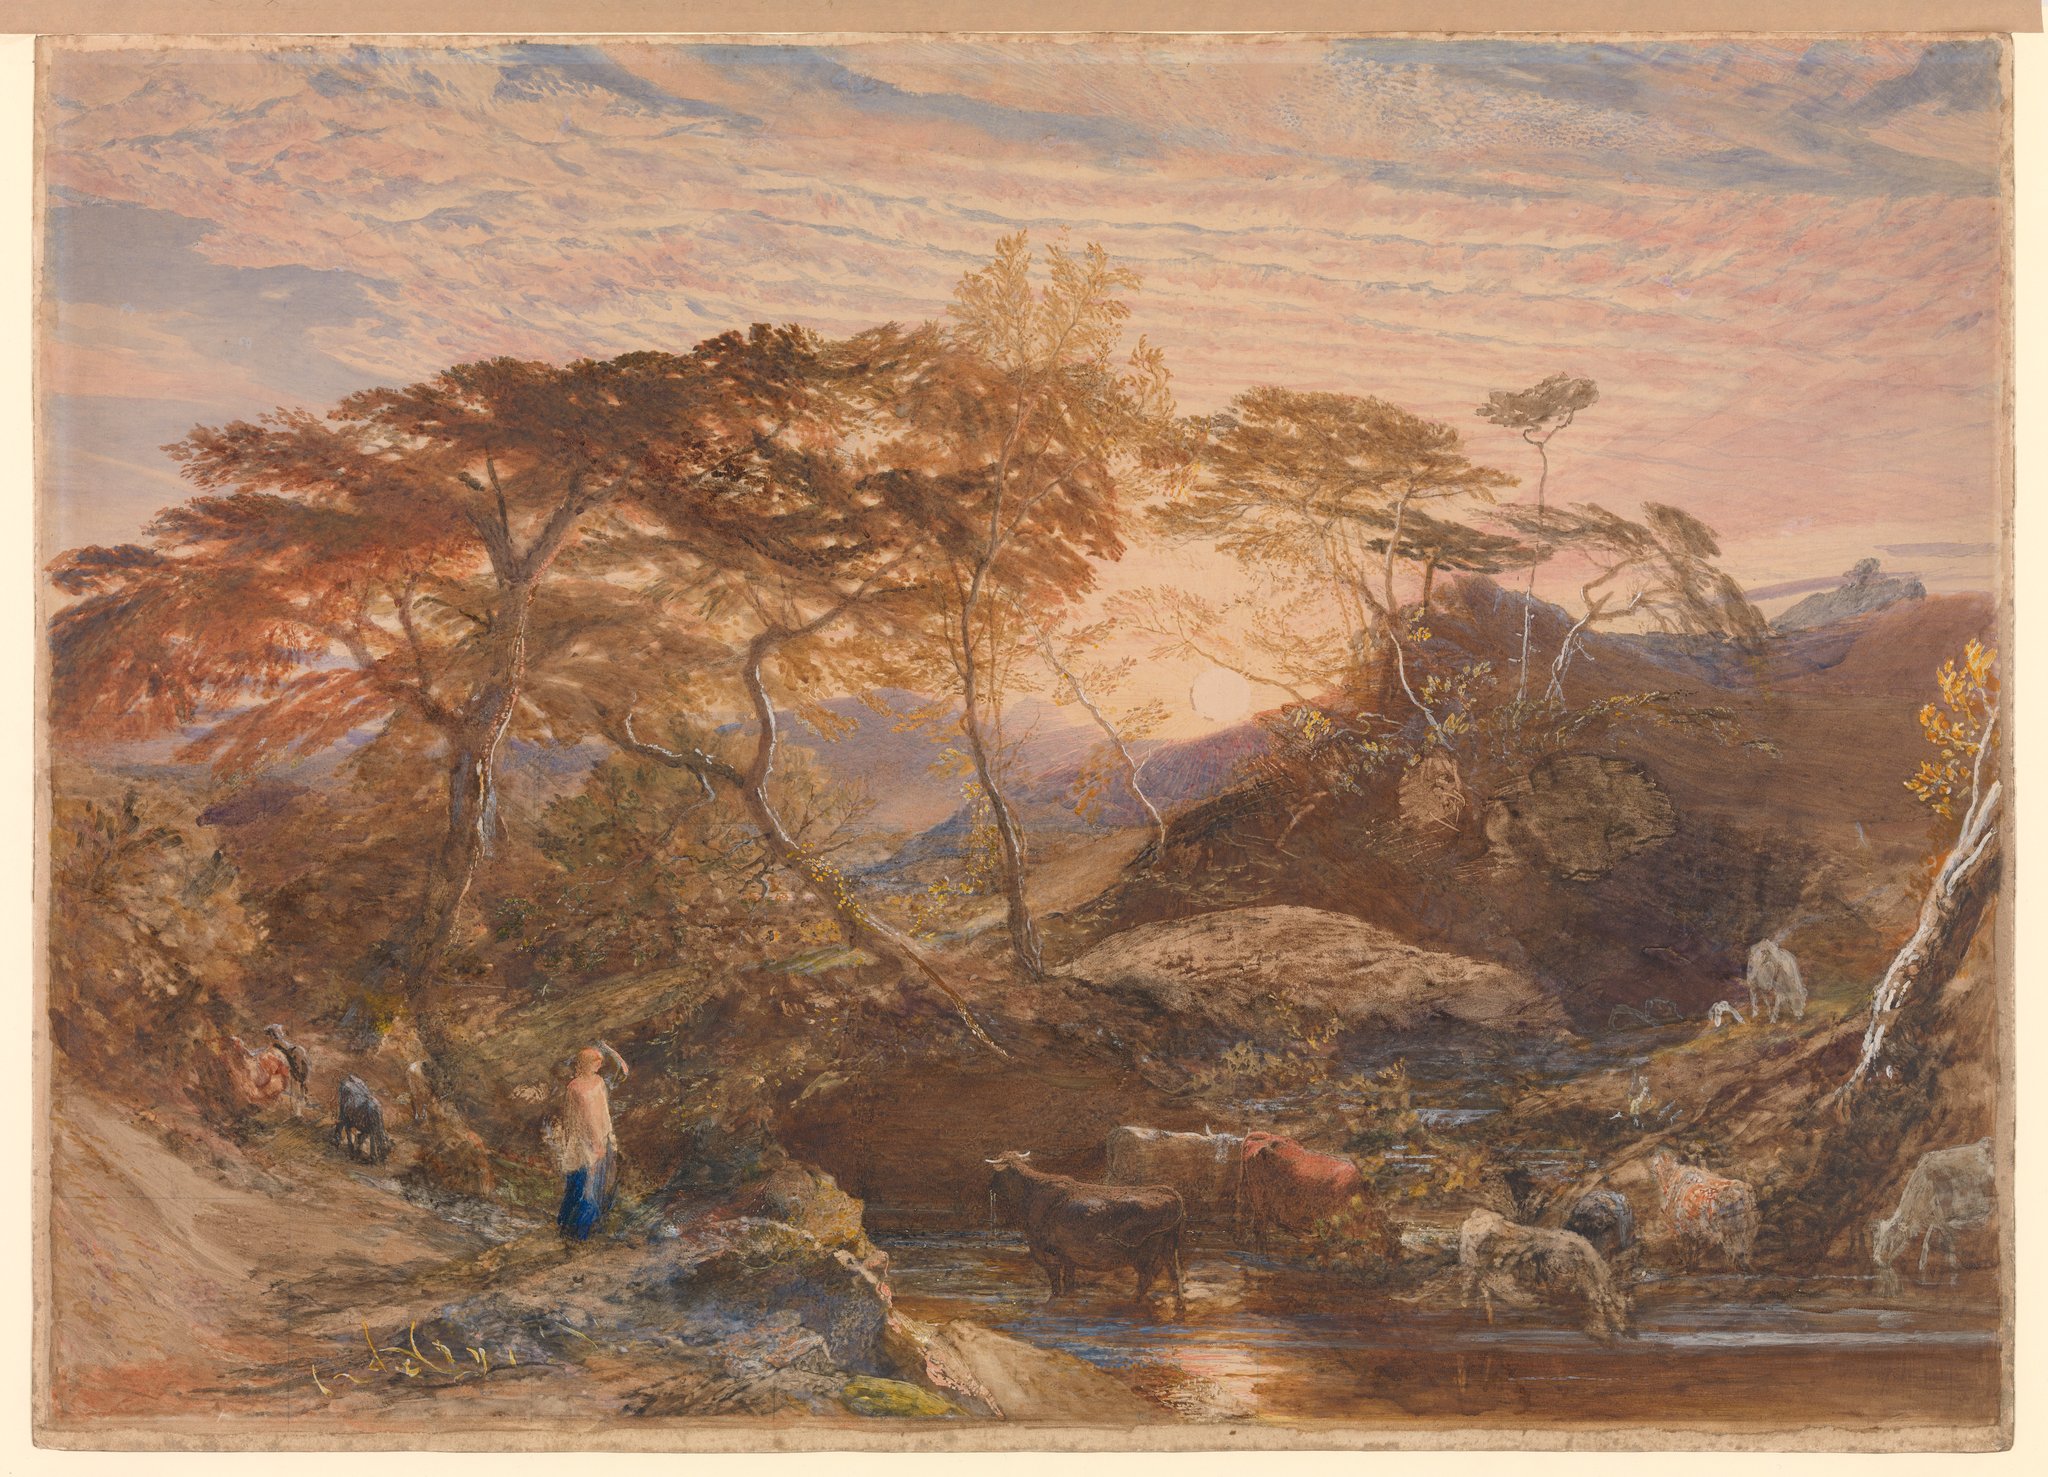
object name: drawing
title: Sabrina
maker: samuel palmer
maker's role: artist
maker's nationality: british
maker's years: 1805-1881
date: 1856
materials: gold, gouache, graphite, gum arabic, shell, watercolor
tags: human figures,animals,hills,landscapes,trees